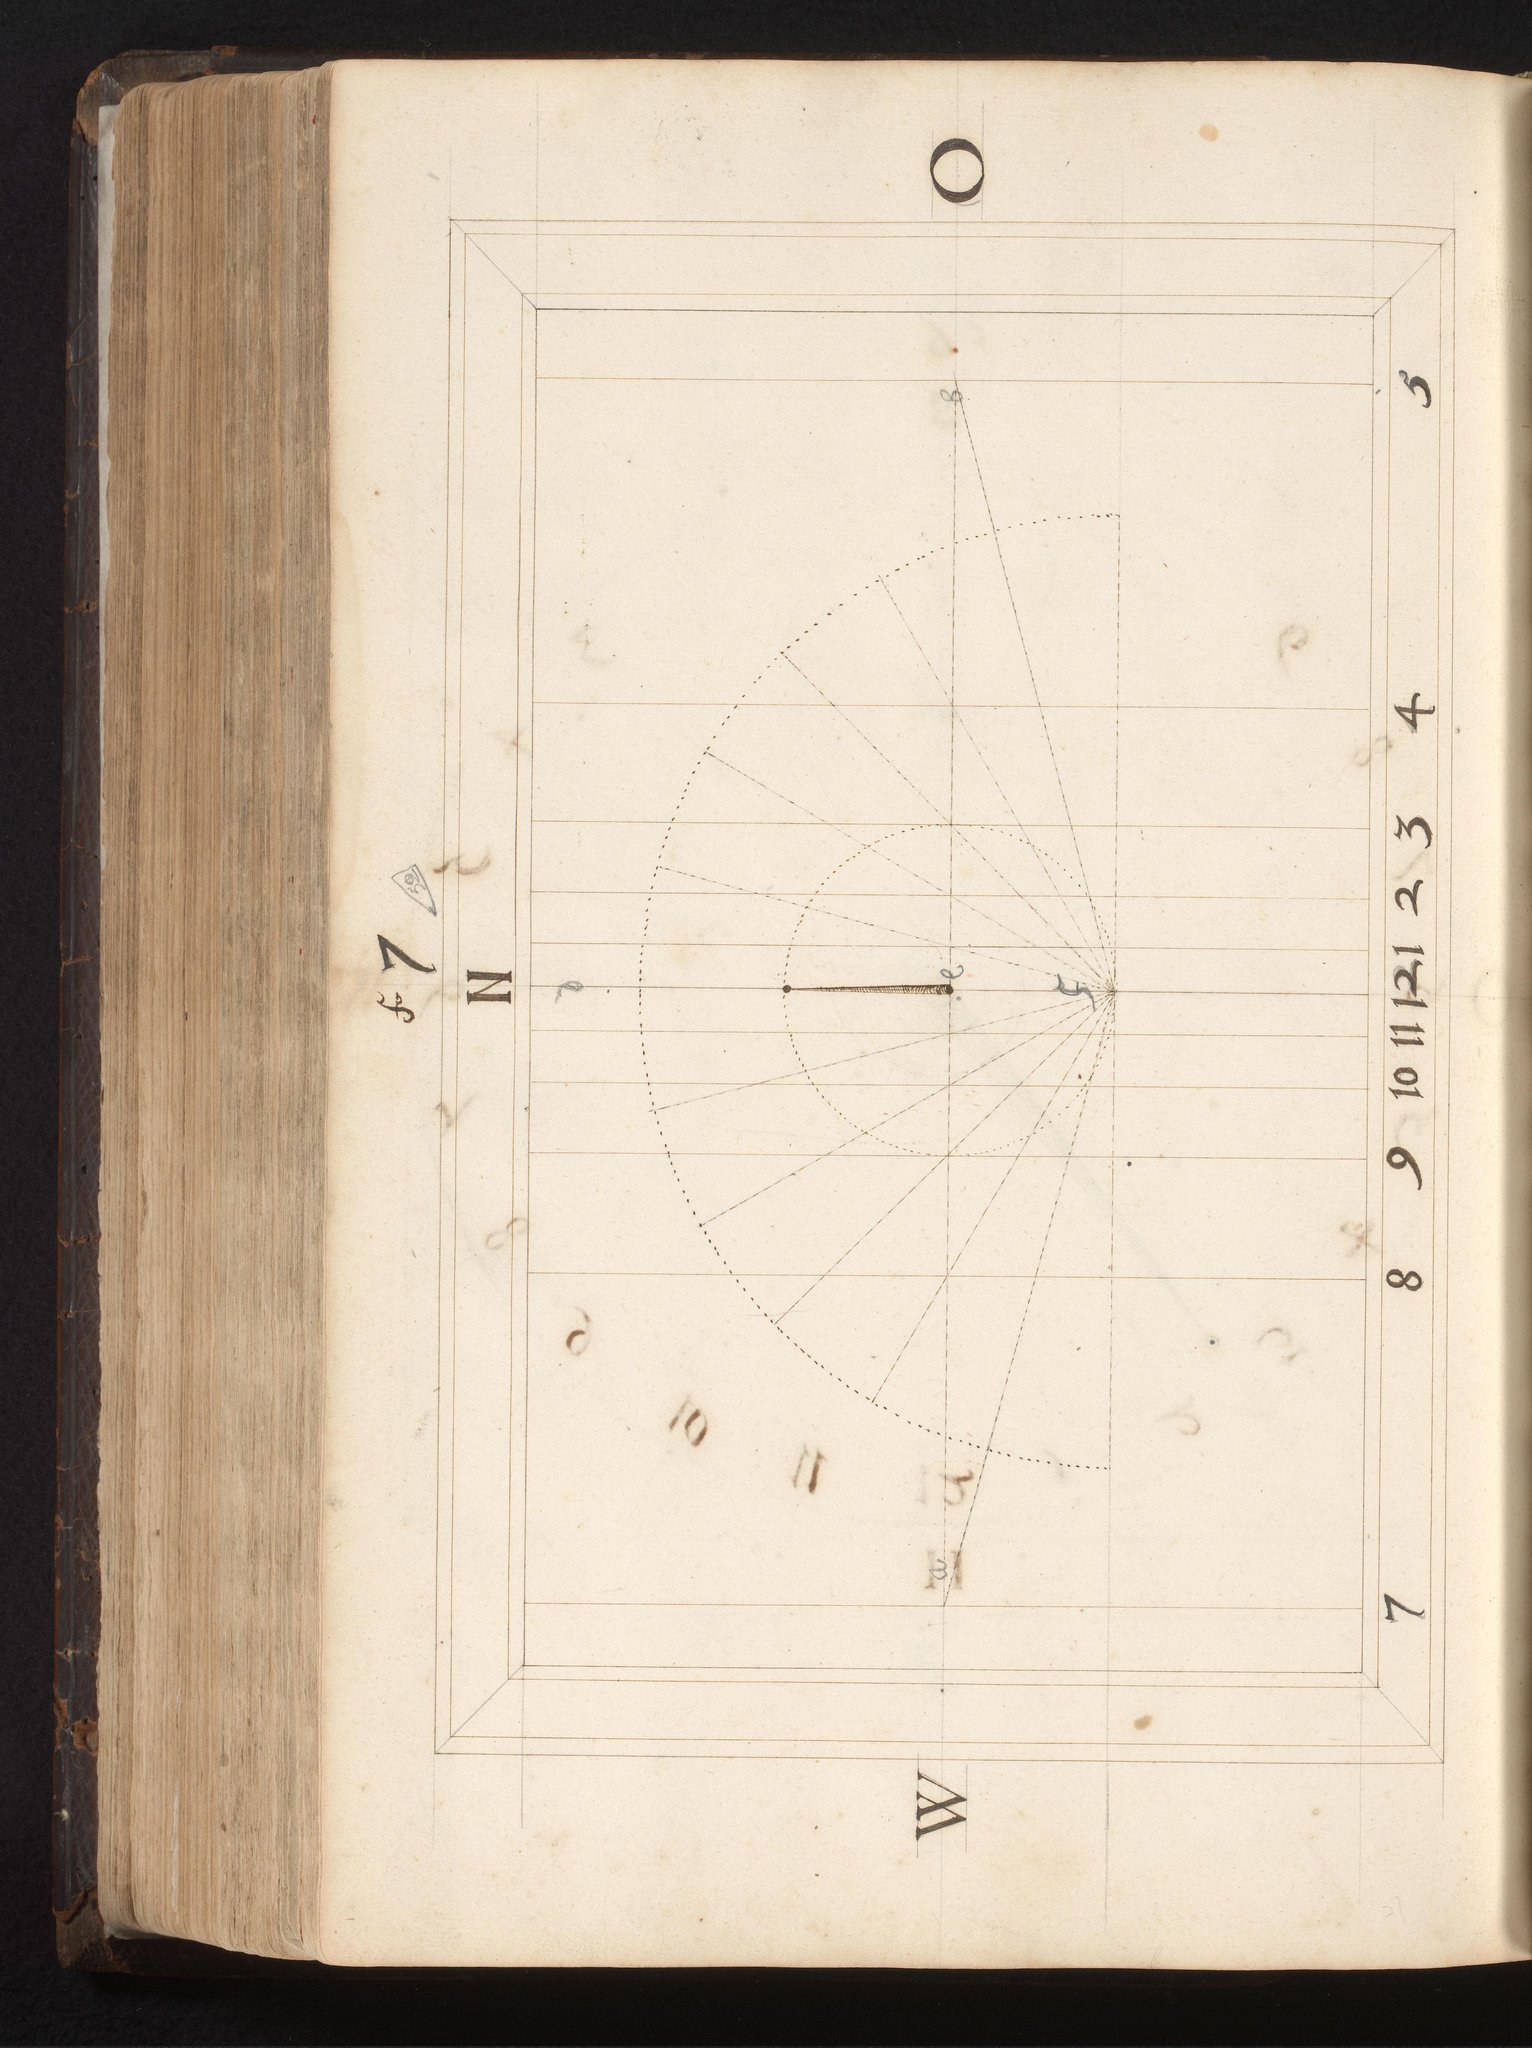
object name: drawing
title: Ontwerp voor een zonnewijzer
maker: Anonymous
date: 1650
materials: ink, paper, pencil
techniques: pen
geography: low countries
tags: sundial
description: Midden links genummerd: Fo 7. Tekening maakt deel uit van een album.